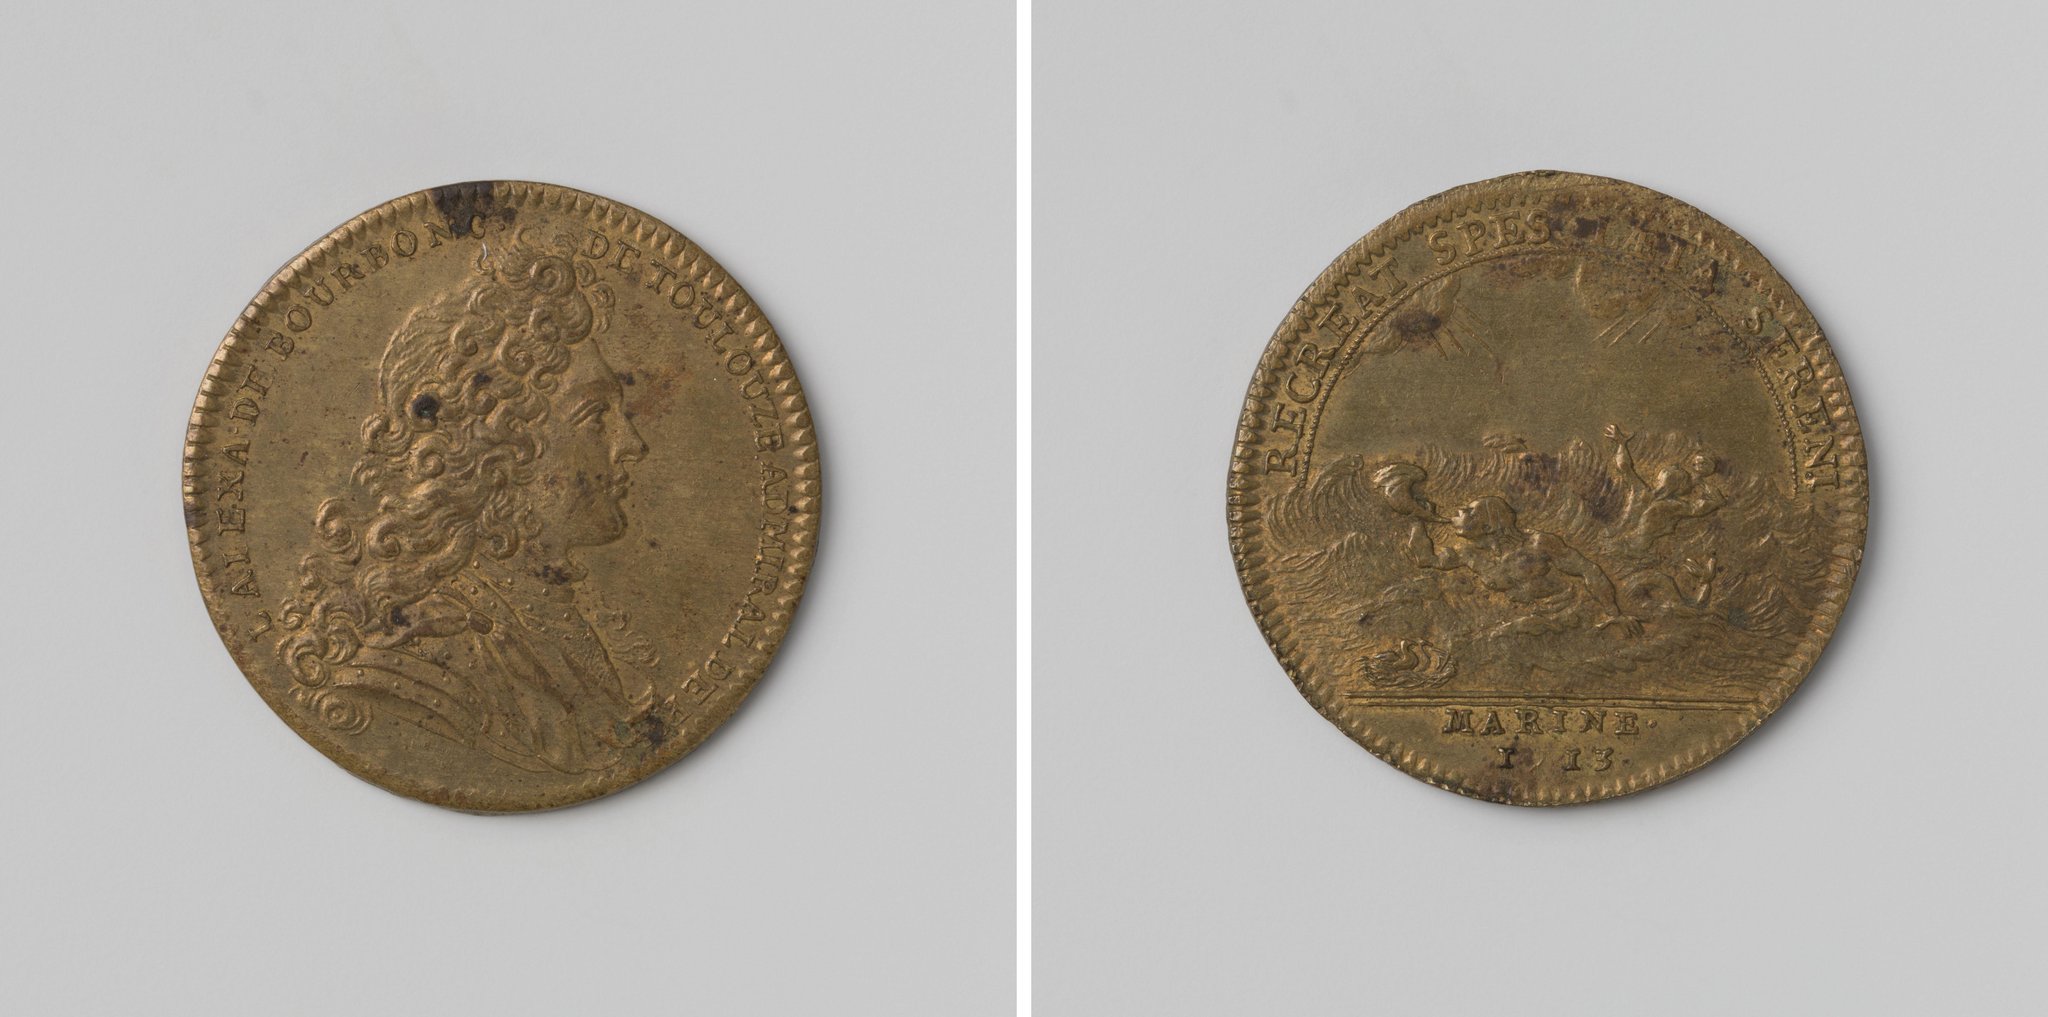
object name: jeton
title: Hoop op een spoedige vrede, rekenpenning geslagen ter ere van Lodewijk Alexander, graaf van Toulouse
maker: Anonymous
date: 1713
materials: brass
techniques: striking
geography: france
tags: louis alexandre (count of toulouse)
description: Messing penning. Voorzijde: borststuk man binnen omschrift. Keerzijde: tritons, die door op bazuinen te blazen, woelige zee pogen te kalmeren binnen omschrift; afsnede: opschrift